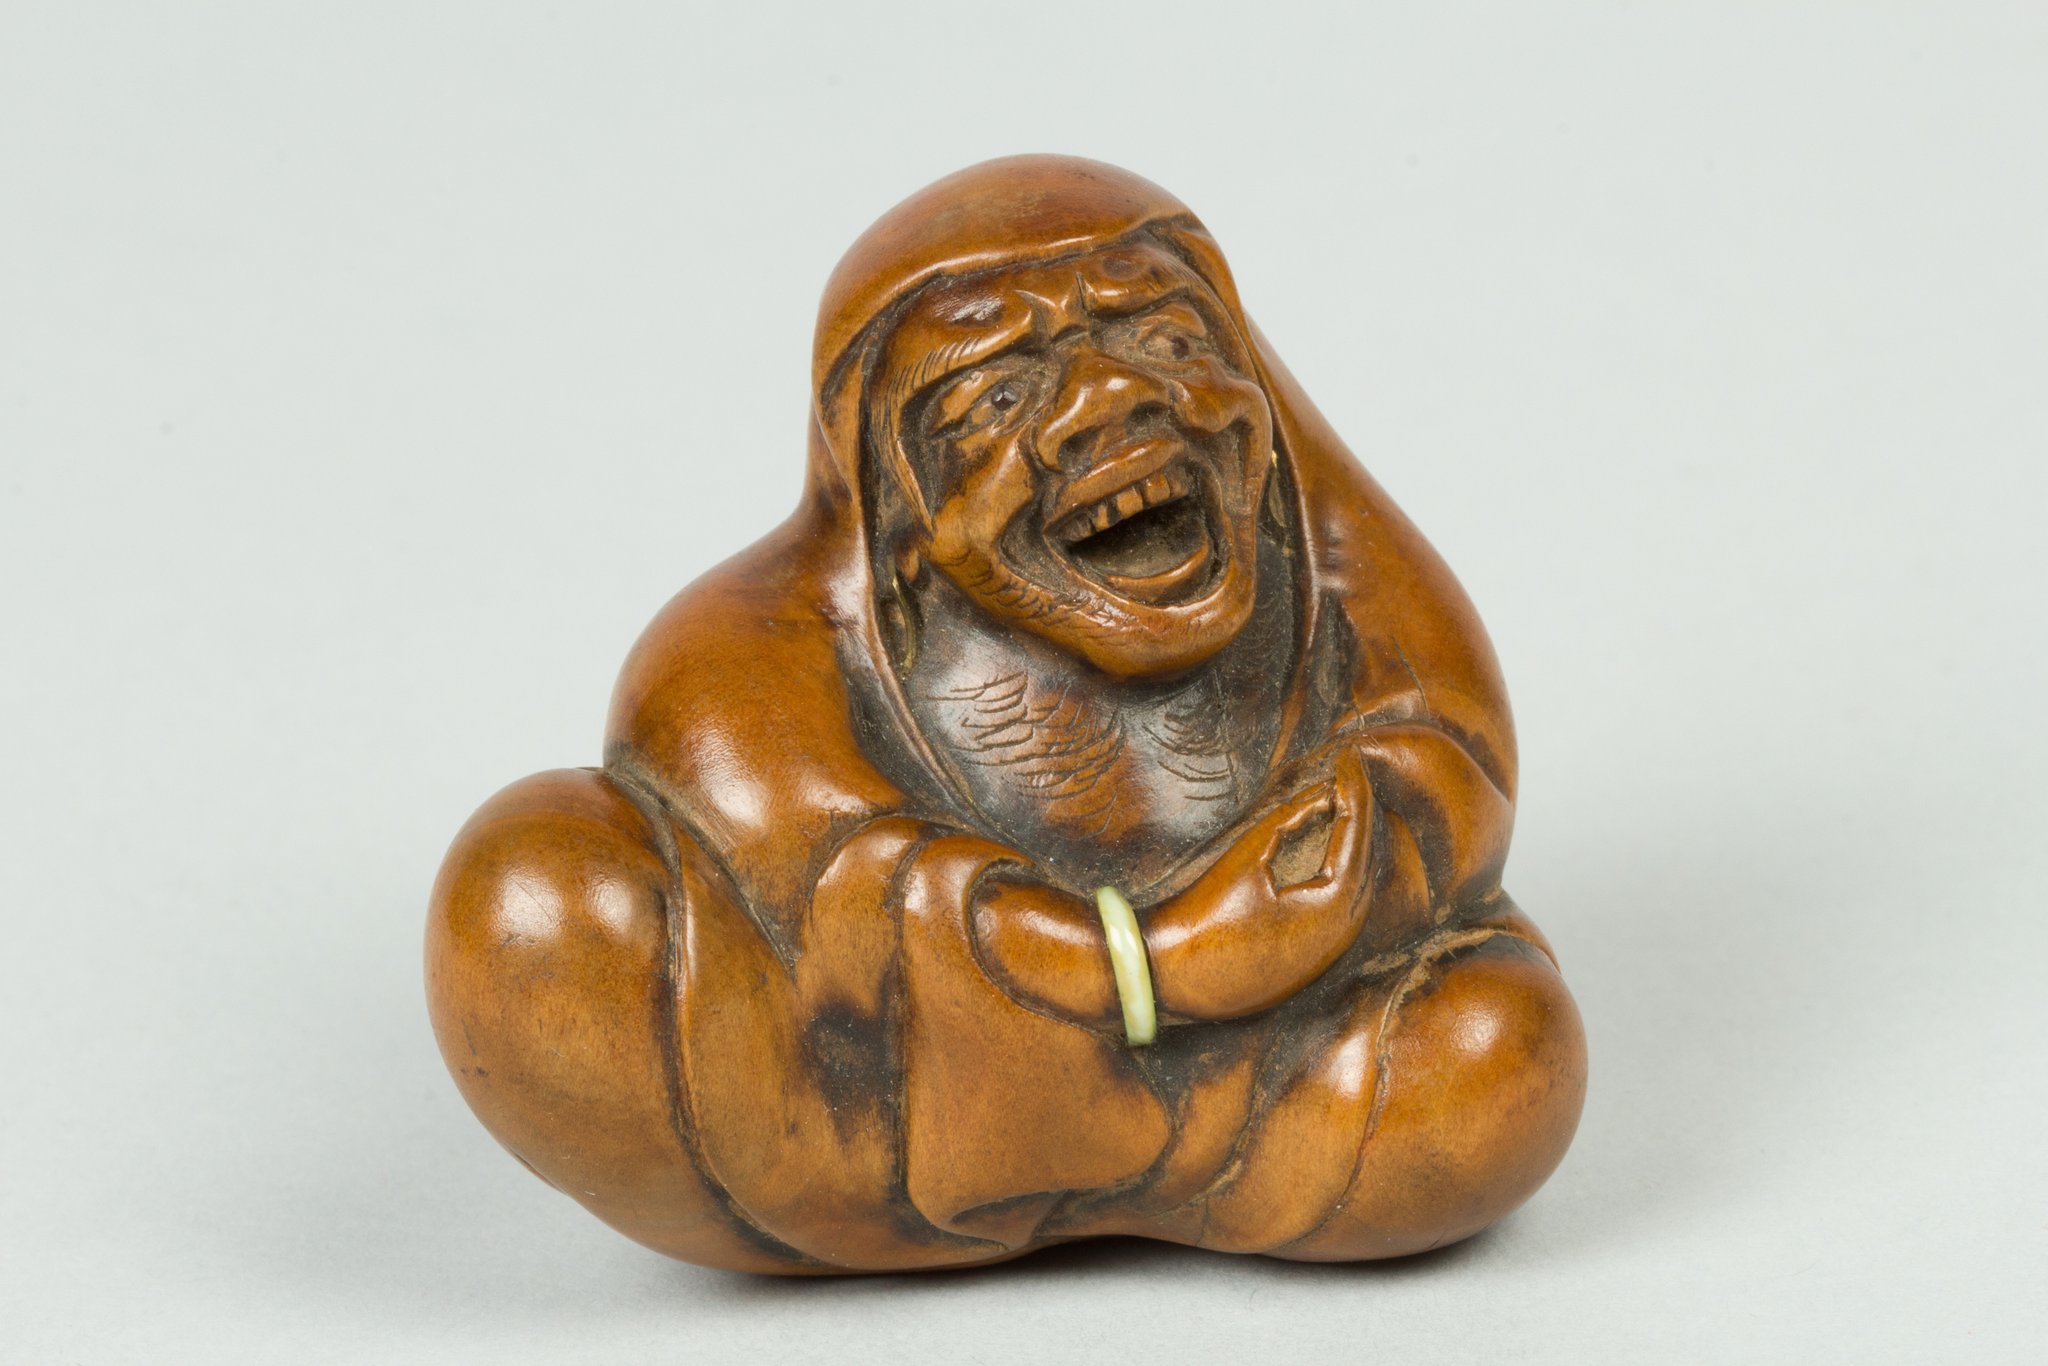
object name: netsuke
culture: japanese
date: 1701-1800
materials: wood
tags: human figures